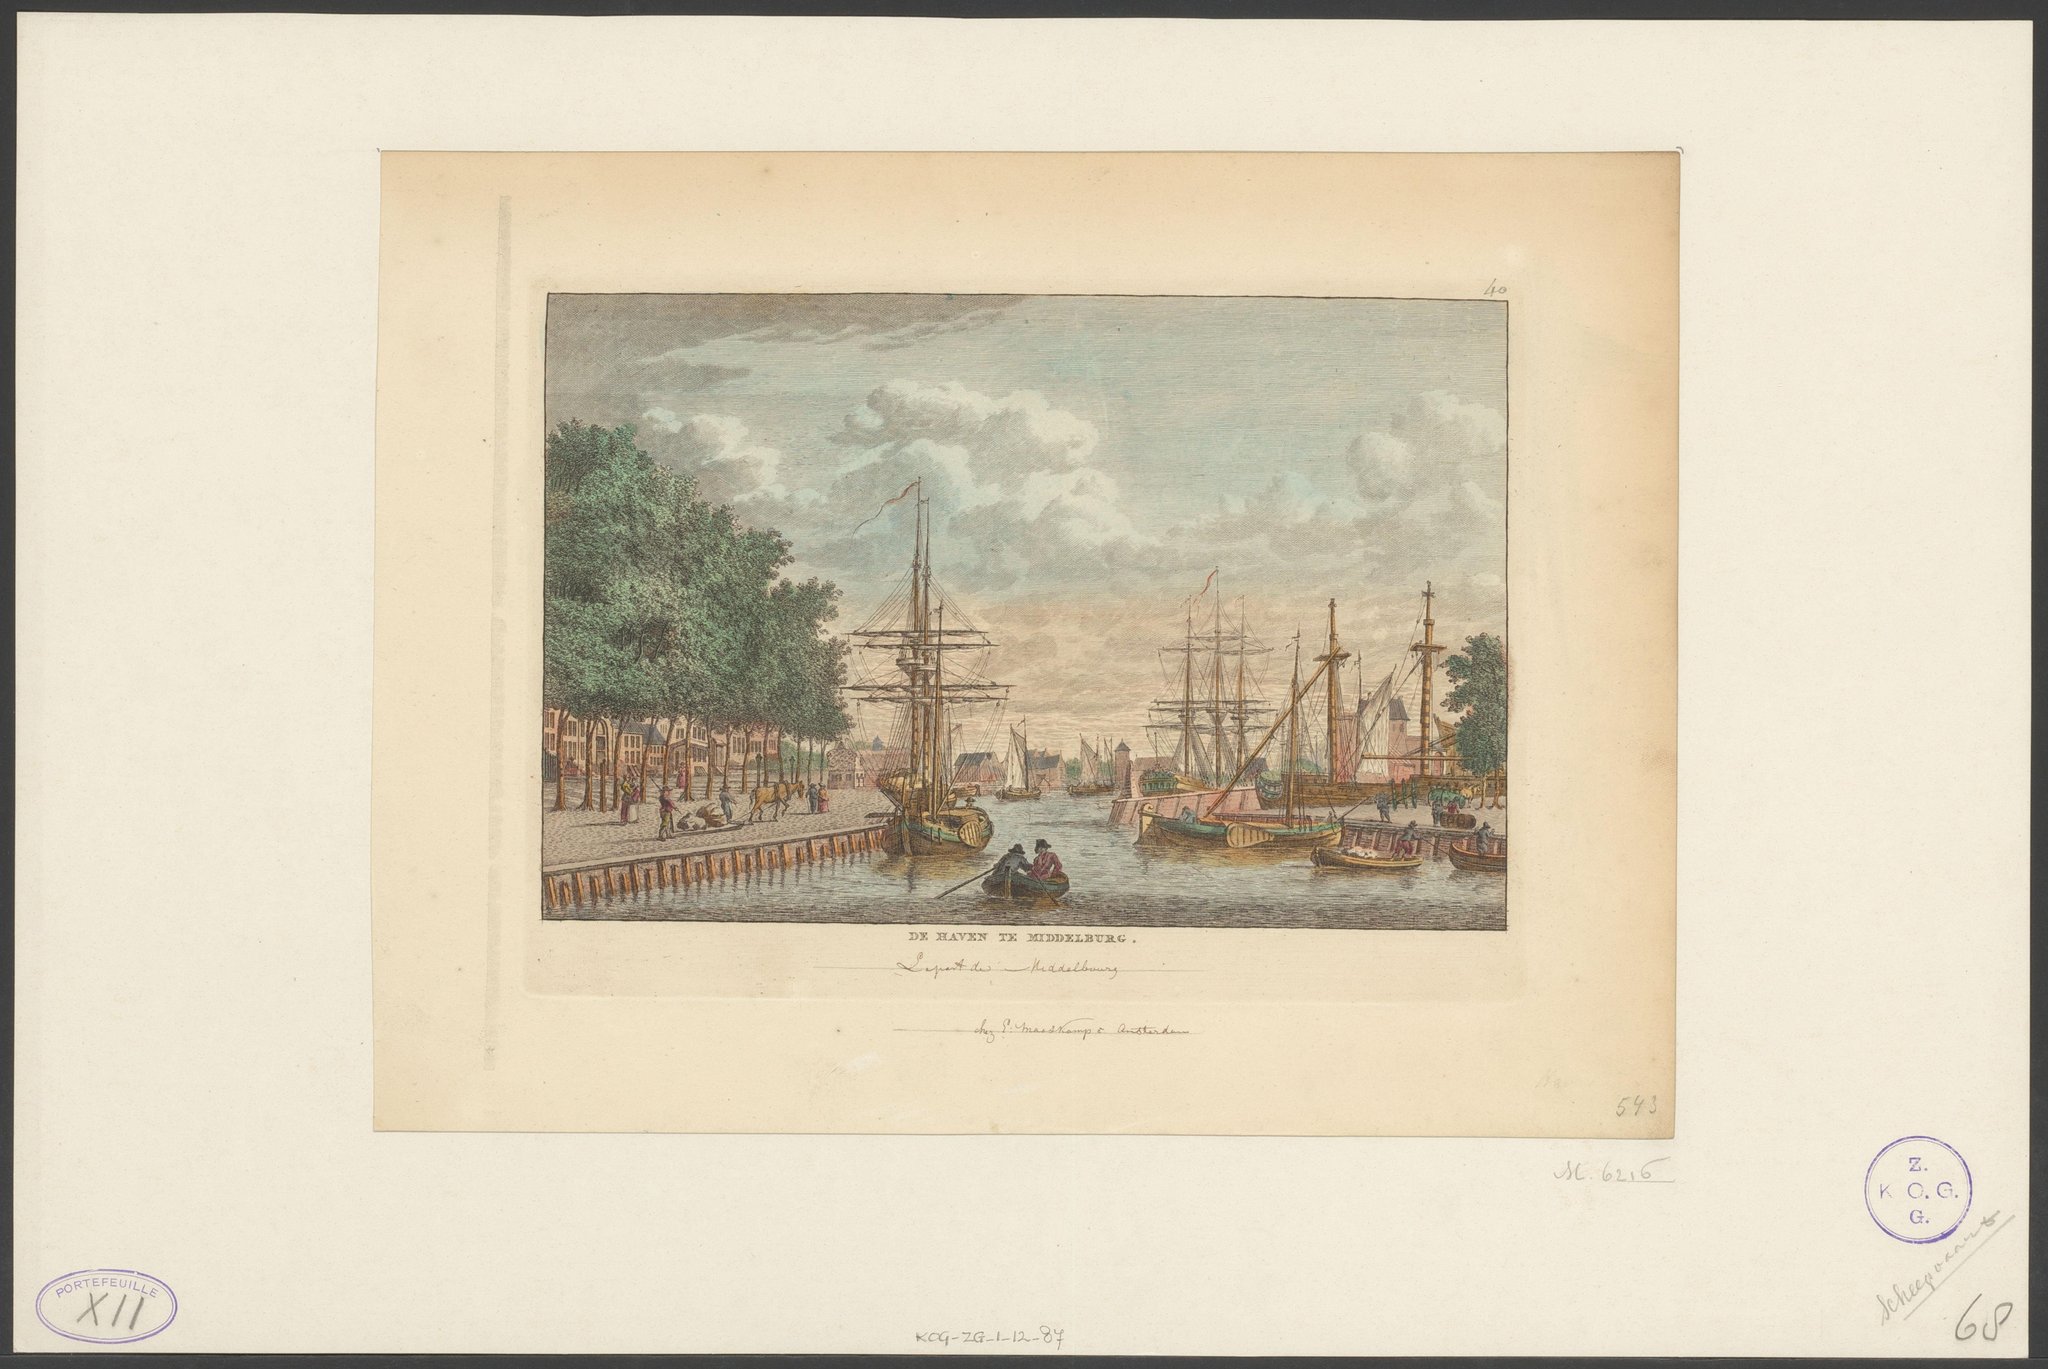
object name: print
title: De haven te Middelburg / Le pont de Middelburg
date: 1824-1825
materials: paper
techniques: engraving, etching, hand coloring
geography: amsterdam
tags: harbour, middelburg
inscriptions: collector's mark: Lugt 1641, stamp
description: Huidige staat van prent uitgegeven als onderdeel van een plaatwerk uit ca. 1824-1825 met 74 (ongenummerde) platen van de belangrijkste topografische gezichten en verschillende zeden en gewoonten in het Verenigd Koninkrijk der Nederlanden, getiteld 'Tableau des principales vues des palais et édifices : représentations et des coutumes et usages, dans les provinces septentrionales du Royaume des Pays-Bas'. Eerdere staat gebruikt in: Vaderlandsche gezichten, of afbeeldingen van den tegenwoordigen staat der Vereenigde Nederlanden (…). Amsterdam: Hendrik Gartman, Willem Vermandel en Jan Willem Smit, 1786-1792. Uitgegeven in afleveringen met ieder een eigen bifolium en inhoudsopgave. Alle prenten in deze publicatie zijn gegraveerd door Carel Frederik Bendorp (I) en, in de meeste gevallen, gebaseerd op tekeningen van Jan Bulthuis.